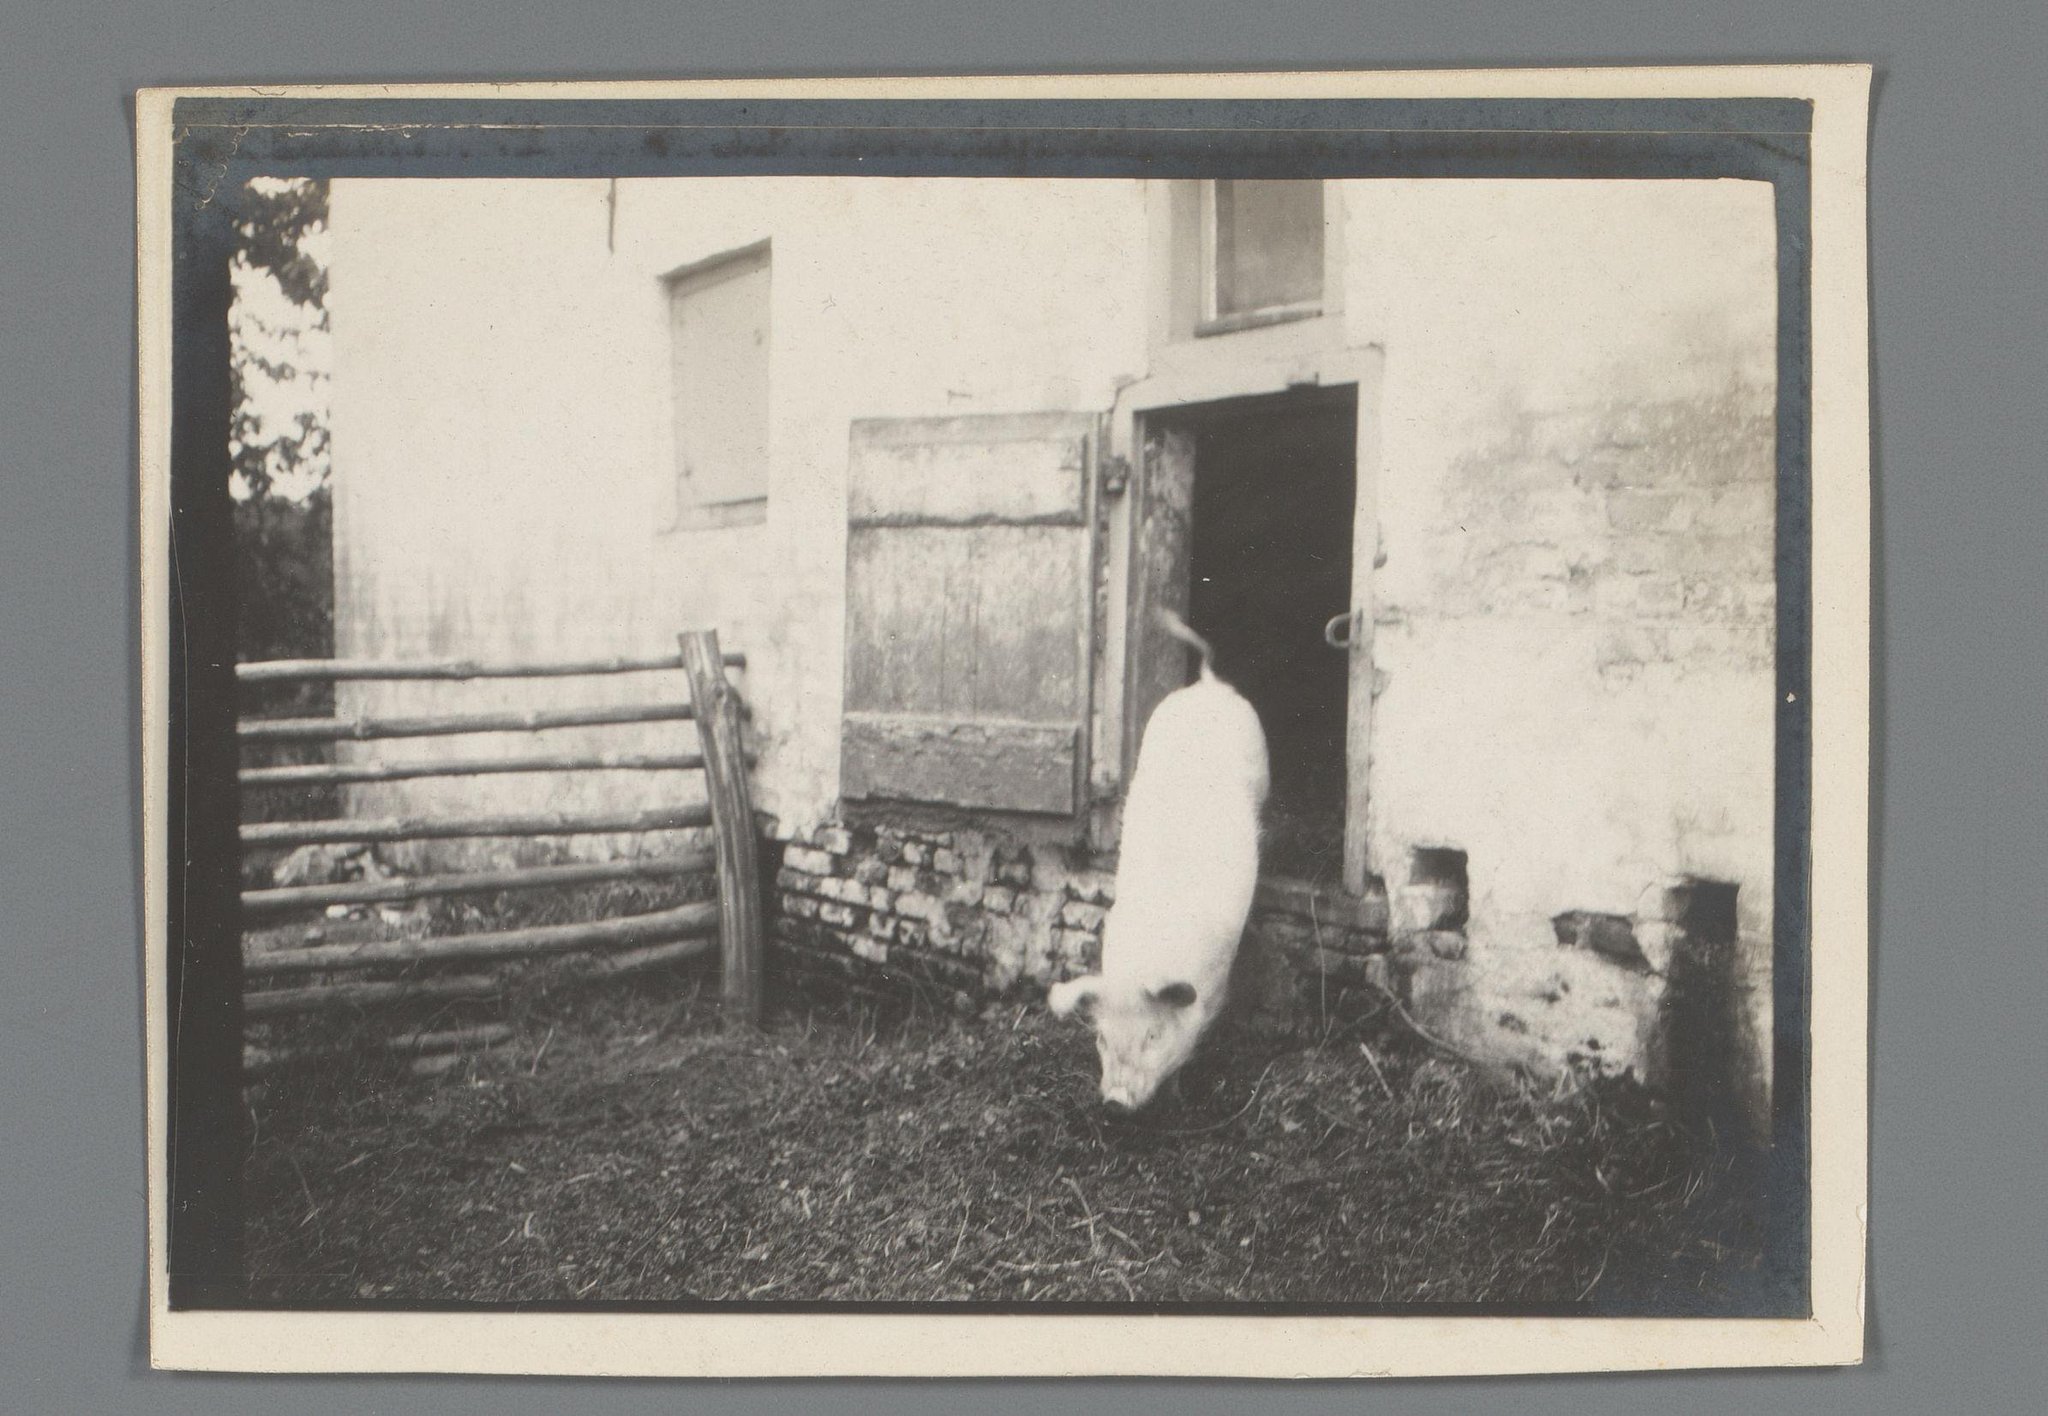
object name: photograph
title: Varken bij een boerderij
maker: willem de jong (fotograaf)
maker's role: arts, fotograaf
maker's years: 1864-1918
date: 1895-1918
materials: paper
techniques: gelatin silver print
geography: netherlands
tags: pig, farm (building)